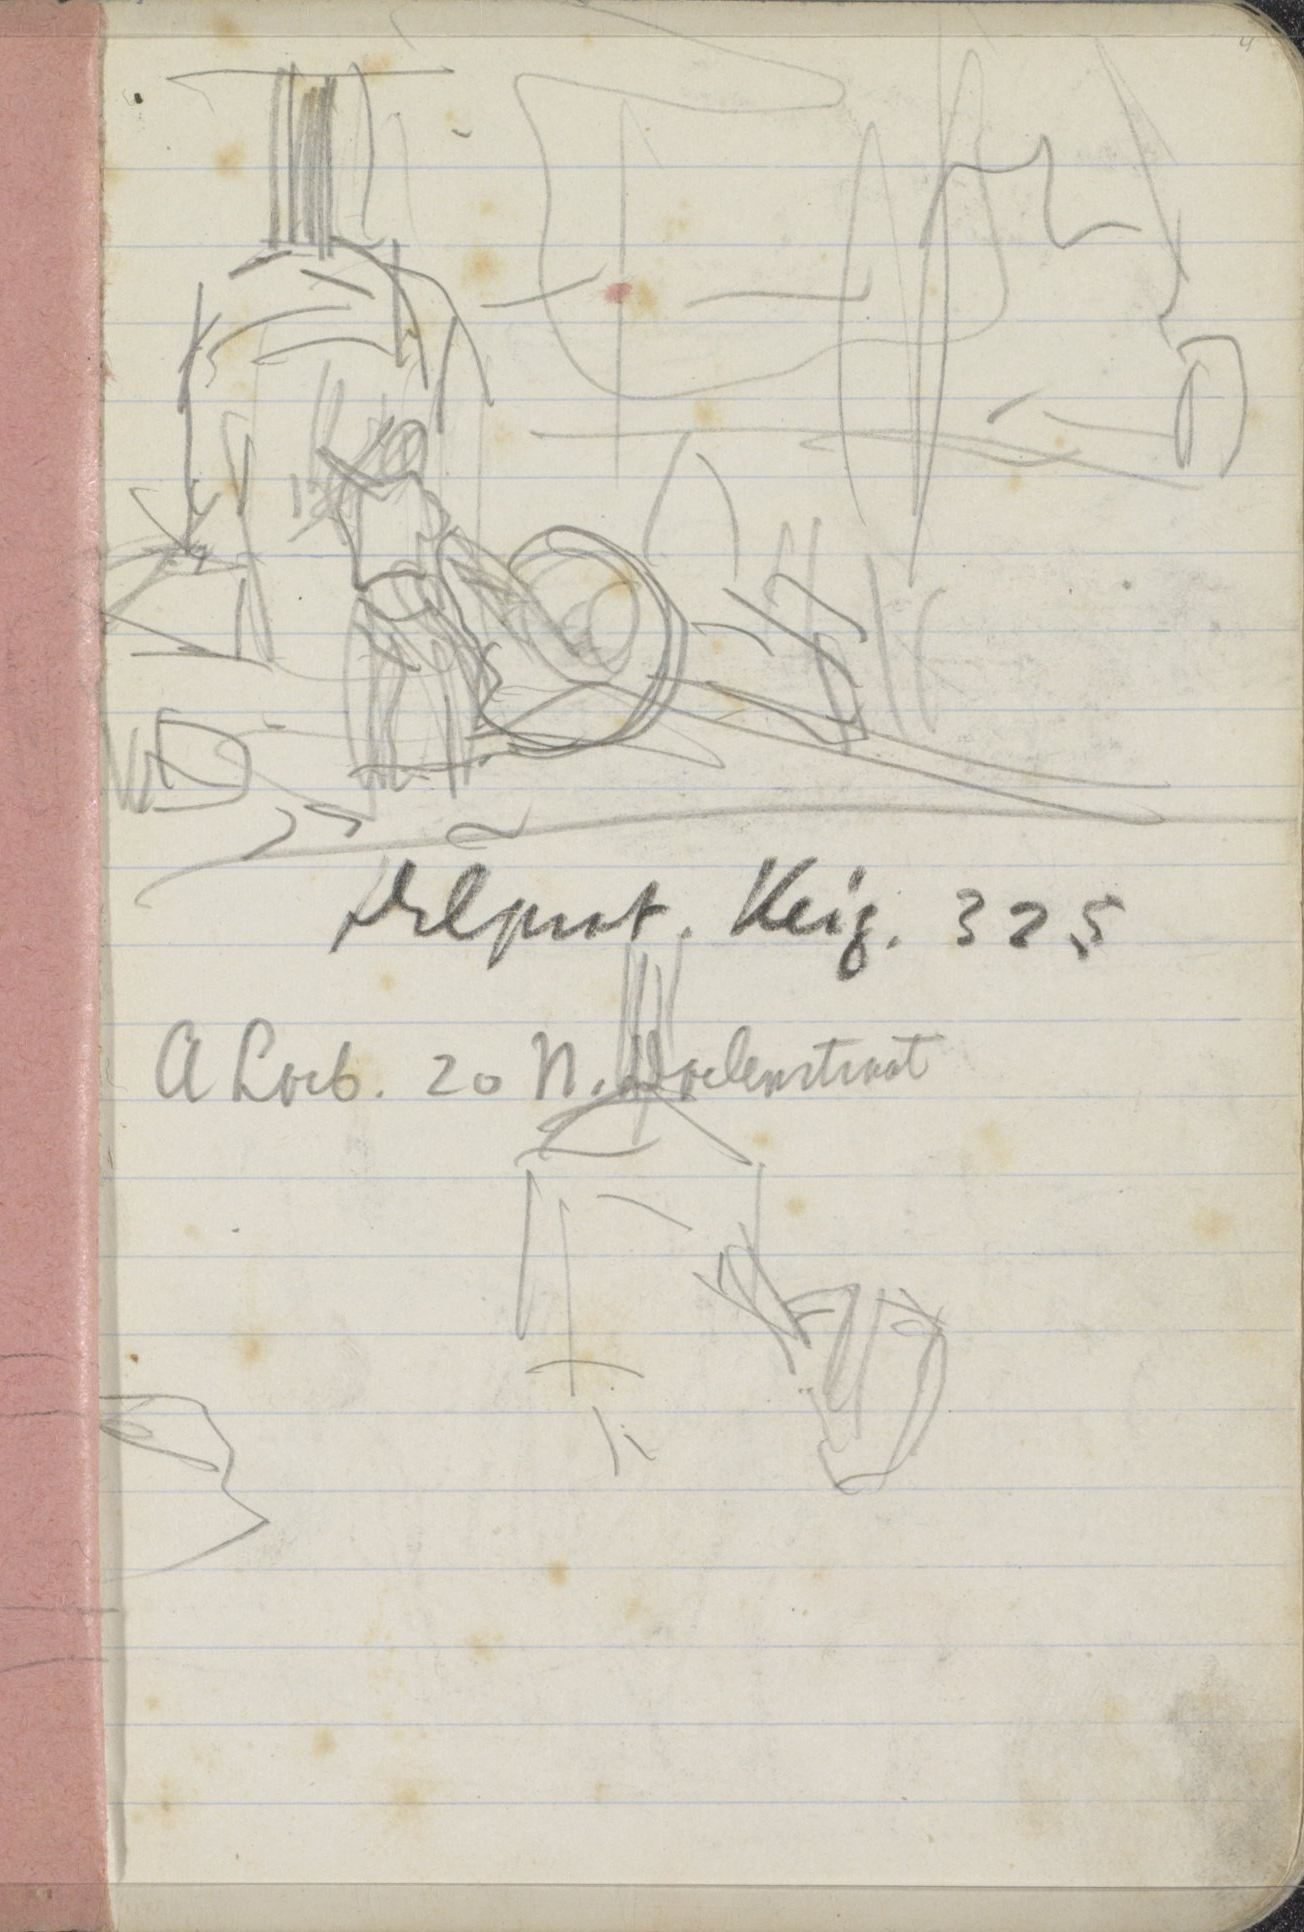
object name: sketchbook leaf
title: Studieblad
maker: george hendrik breitner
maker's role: draughtsman, painter, print maker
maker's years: 1857-1923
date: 1898-1902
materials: pencil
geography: amsterdam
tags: working class, labourers, civic architecture; edifices; dwellings, amsterdam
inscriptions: annotation: ‘Dilpoot[?] Keiz. 325/ A Lorb. 20 N. Doelenstraat’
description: Boven mogelijk een studie van een arbeider voor gebouwen. Pagina 4 uit een schetsboek met 42 bladen.